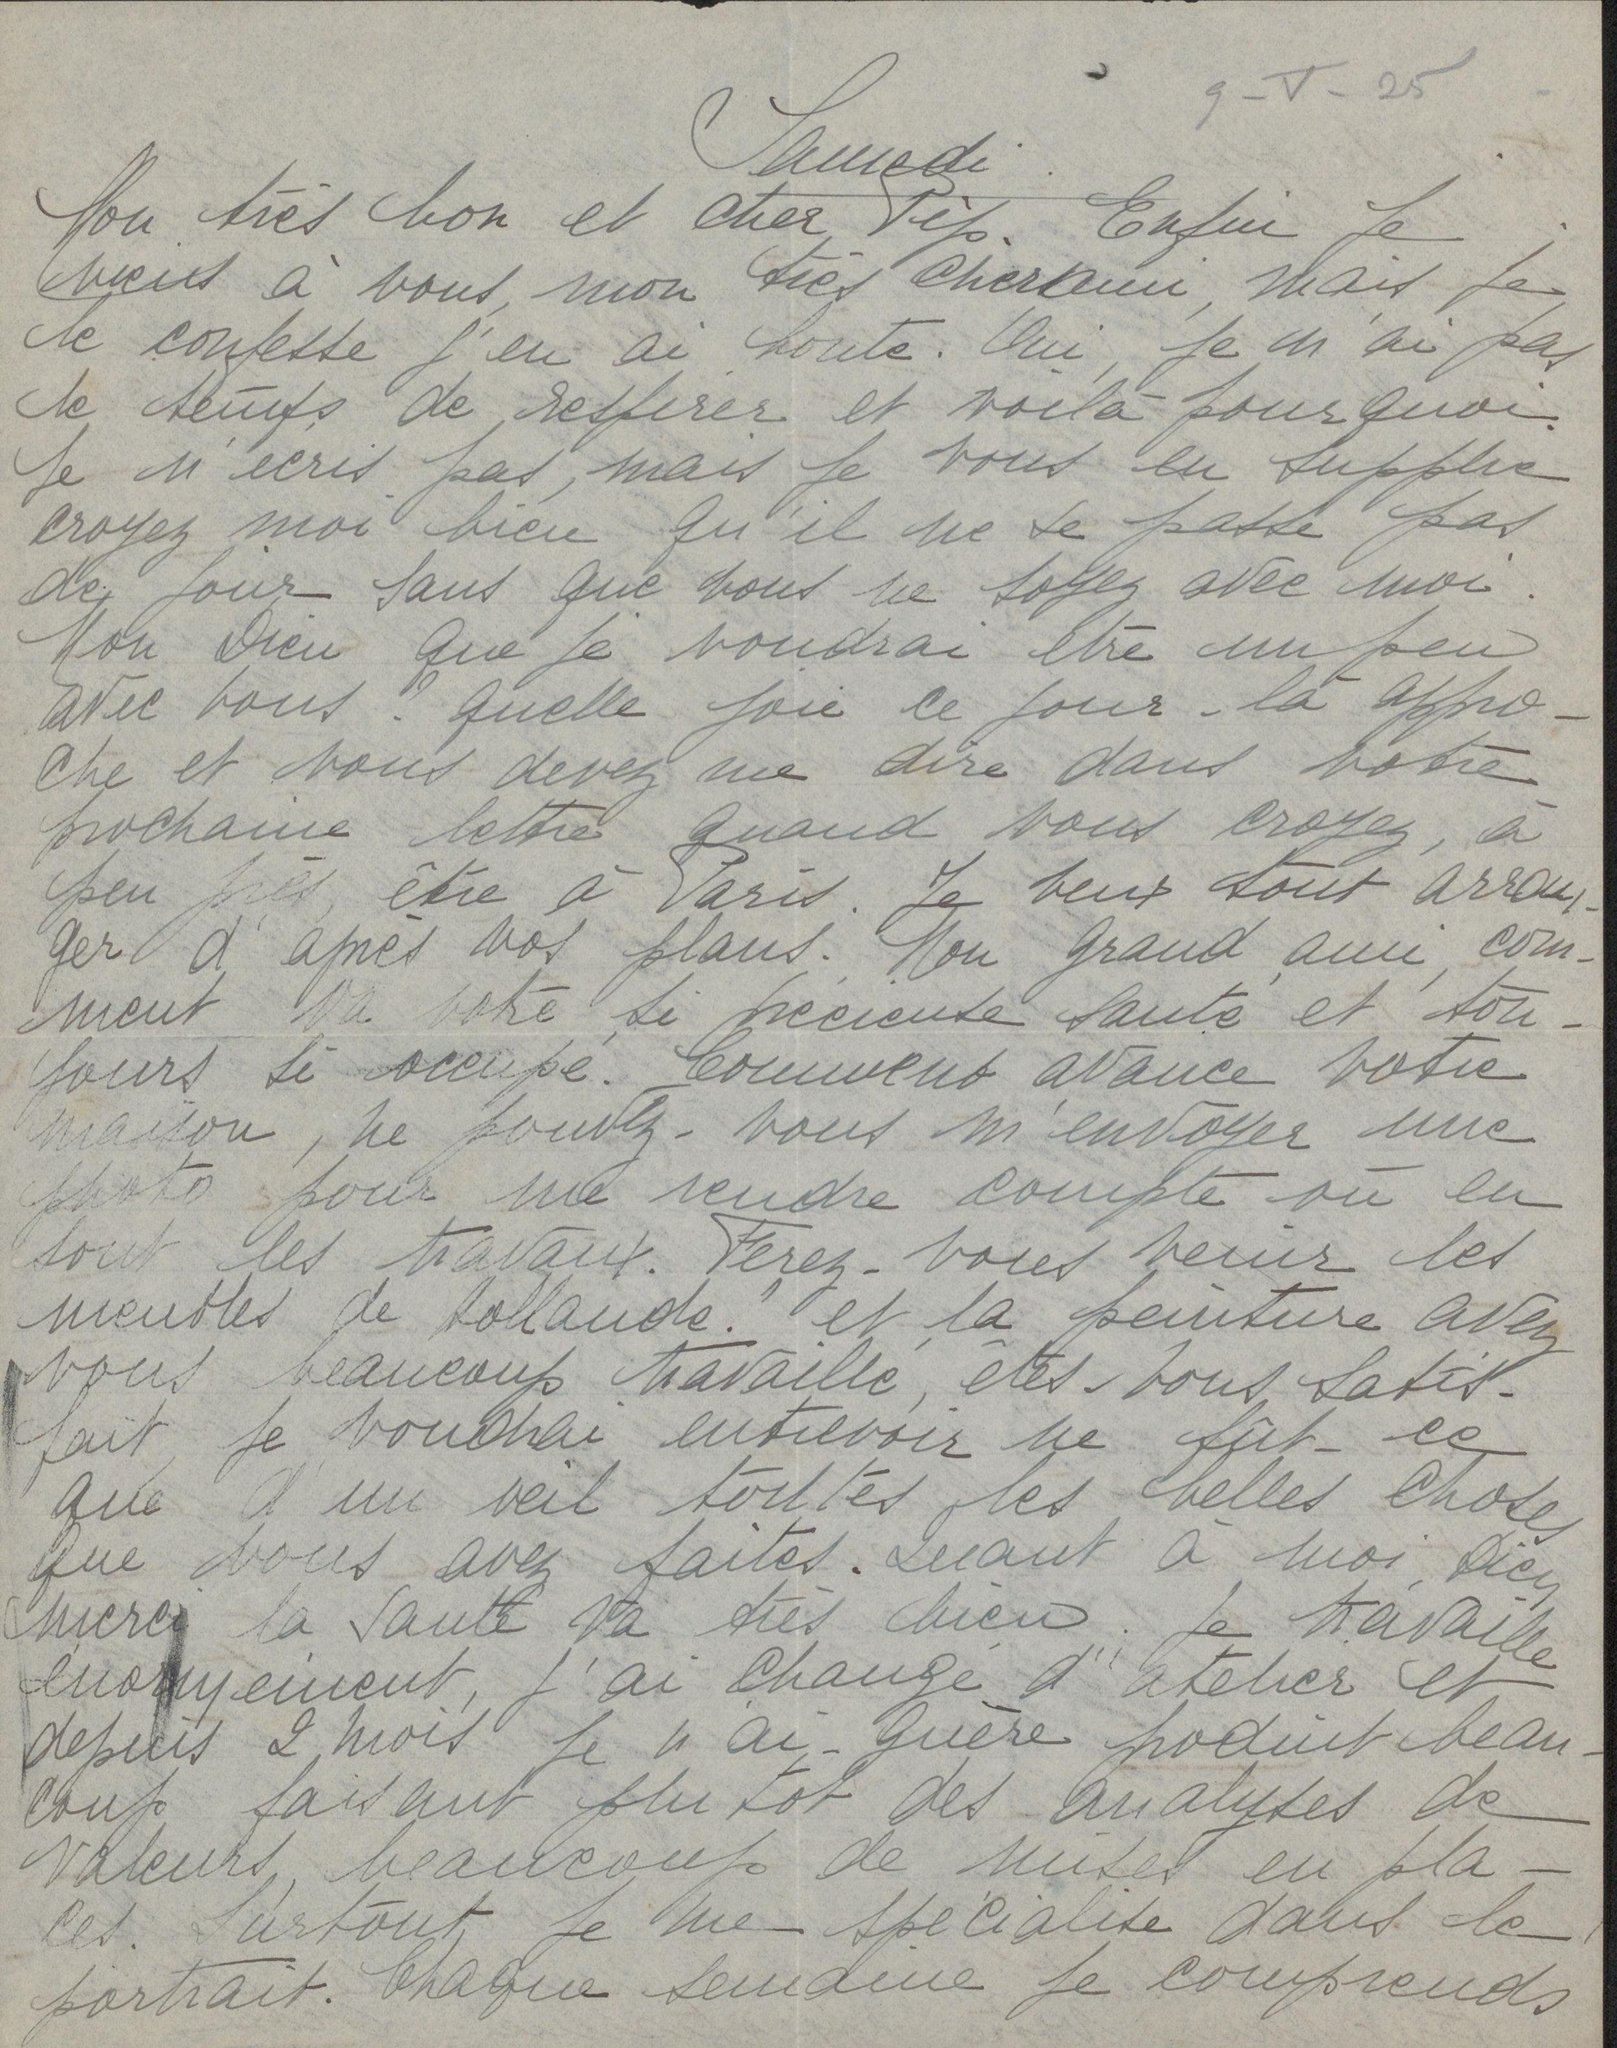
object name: letter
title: Brief aan Philip Zilcken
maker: rose imel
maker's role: draughtsman, painter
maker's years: 1901-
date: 1911-1930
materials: ink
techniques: pen, writing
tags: middelburg, paris, print maker, isodoor boasson, sculptor, théophile alexandre steinlen, painter, draughtsman, philip zilcken, art trade, art shop, the graphic arts, anonymous historical person portrayed, painting (including book-illumination, miniature-painting), workshop, studio of the artist (in general)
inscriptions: collector's mark: ‘RPK’